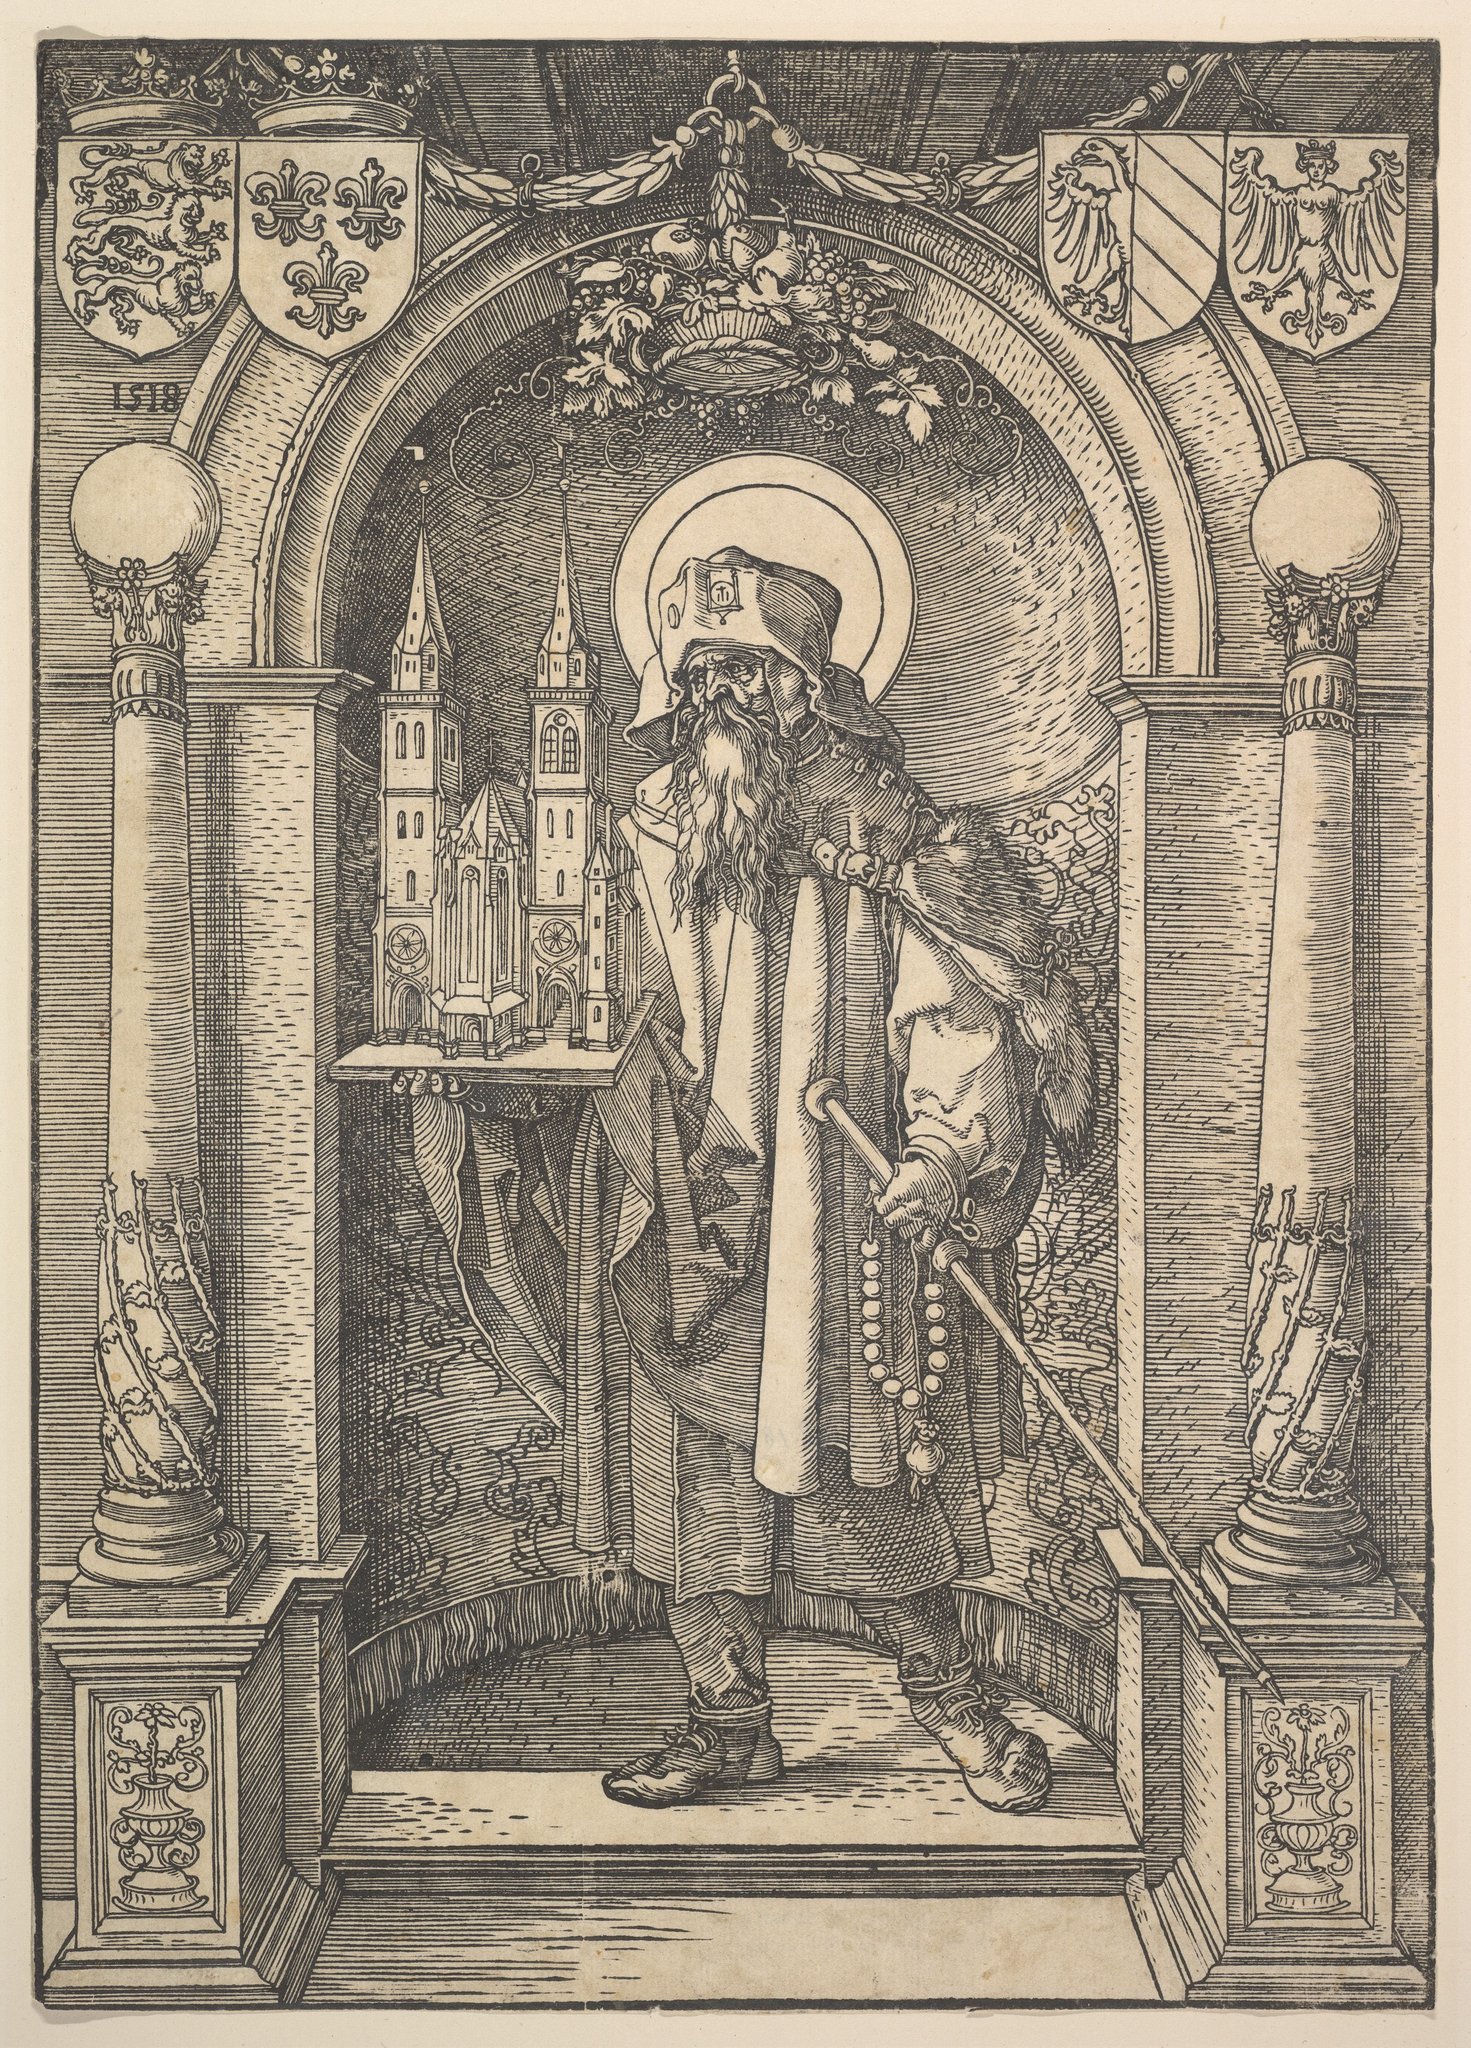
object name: print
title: Saint Sebald in a Niche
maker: albrecht dürer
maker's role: artist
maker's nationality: german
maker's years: 1471-1528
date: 1518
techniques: woodcut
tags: saints,emblems